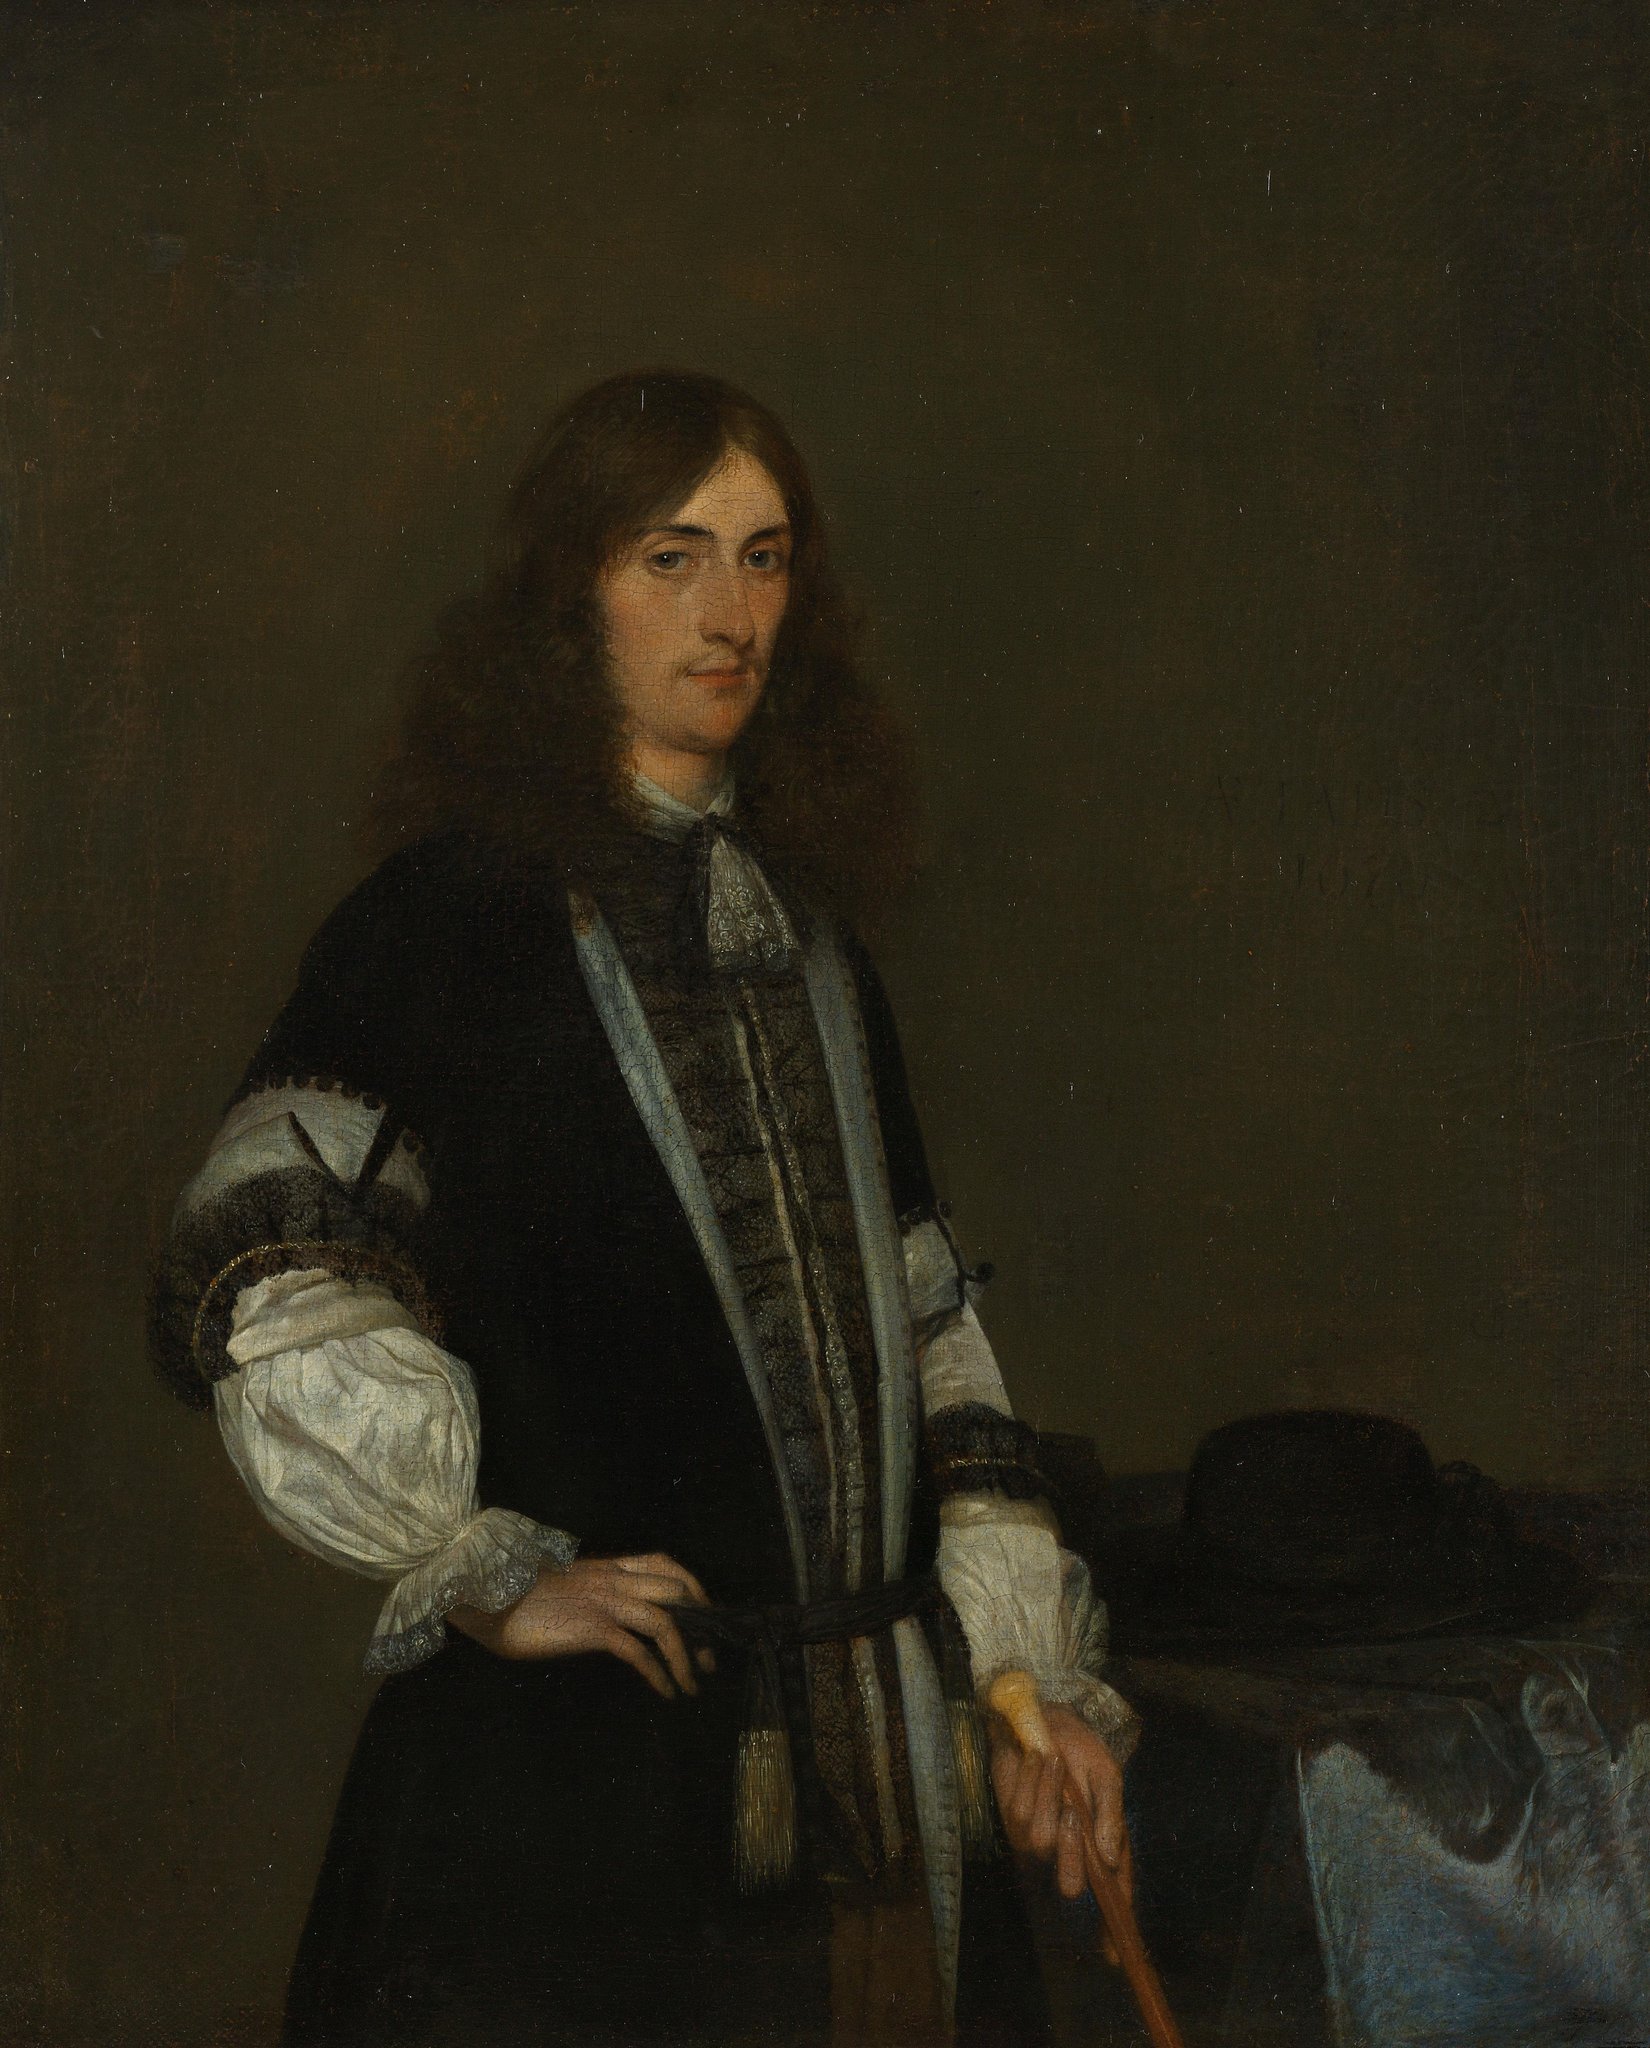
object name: painting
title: François de Vicq, Burgomaster of Amsterdam for several Terms from 1697on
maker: gerard ter borch (ii)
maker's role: draughtsman, painter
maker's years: 1617-1681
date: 1670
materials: canvas, oil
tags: mayor, burgomaster, historical persons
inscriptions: signature, date and inscription: ‘AETATIS 24 1670 GTB’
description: Zie SK-A-2418 voor het schilderij van zijn echtgenote Aletta Pancras (1649-1707) en BI-1887-1463-87 voor de tekening naar dat schilderij. Zie BI-1887-1463-88 voor de tekening naar het geschilderde portret van zijn schoonmoeder Petronella de Waert (1628-1709), dat zich nu in de collectie van het Museo del Prado bevindt. Het portret zijn schoonvader Nicolaes Pancras (1622-1678) zit in de collectie van de Kunsthalle Hamburg.